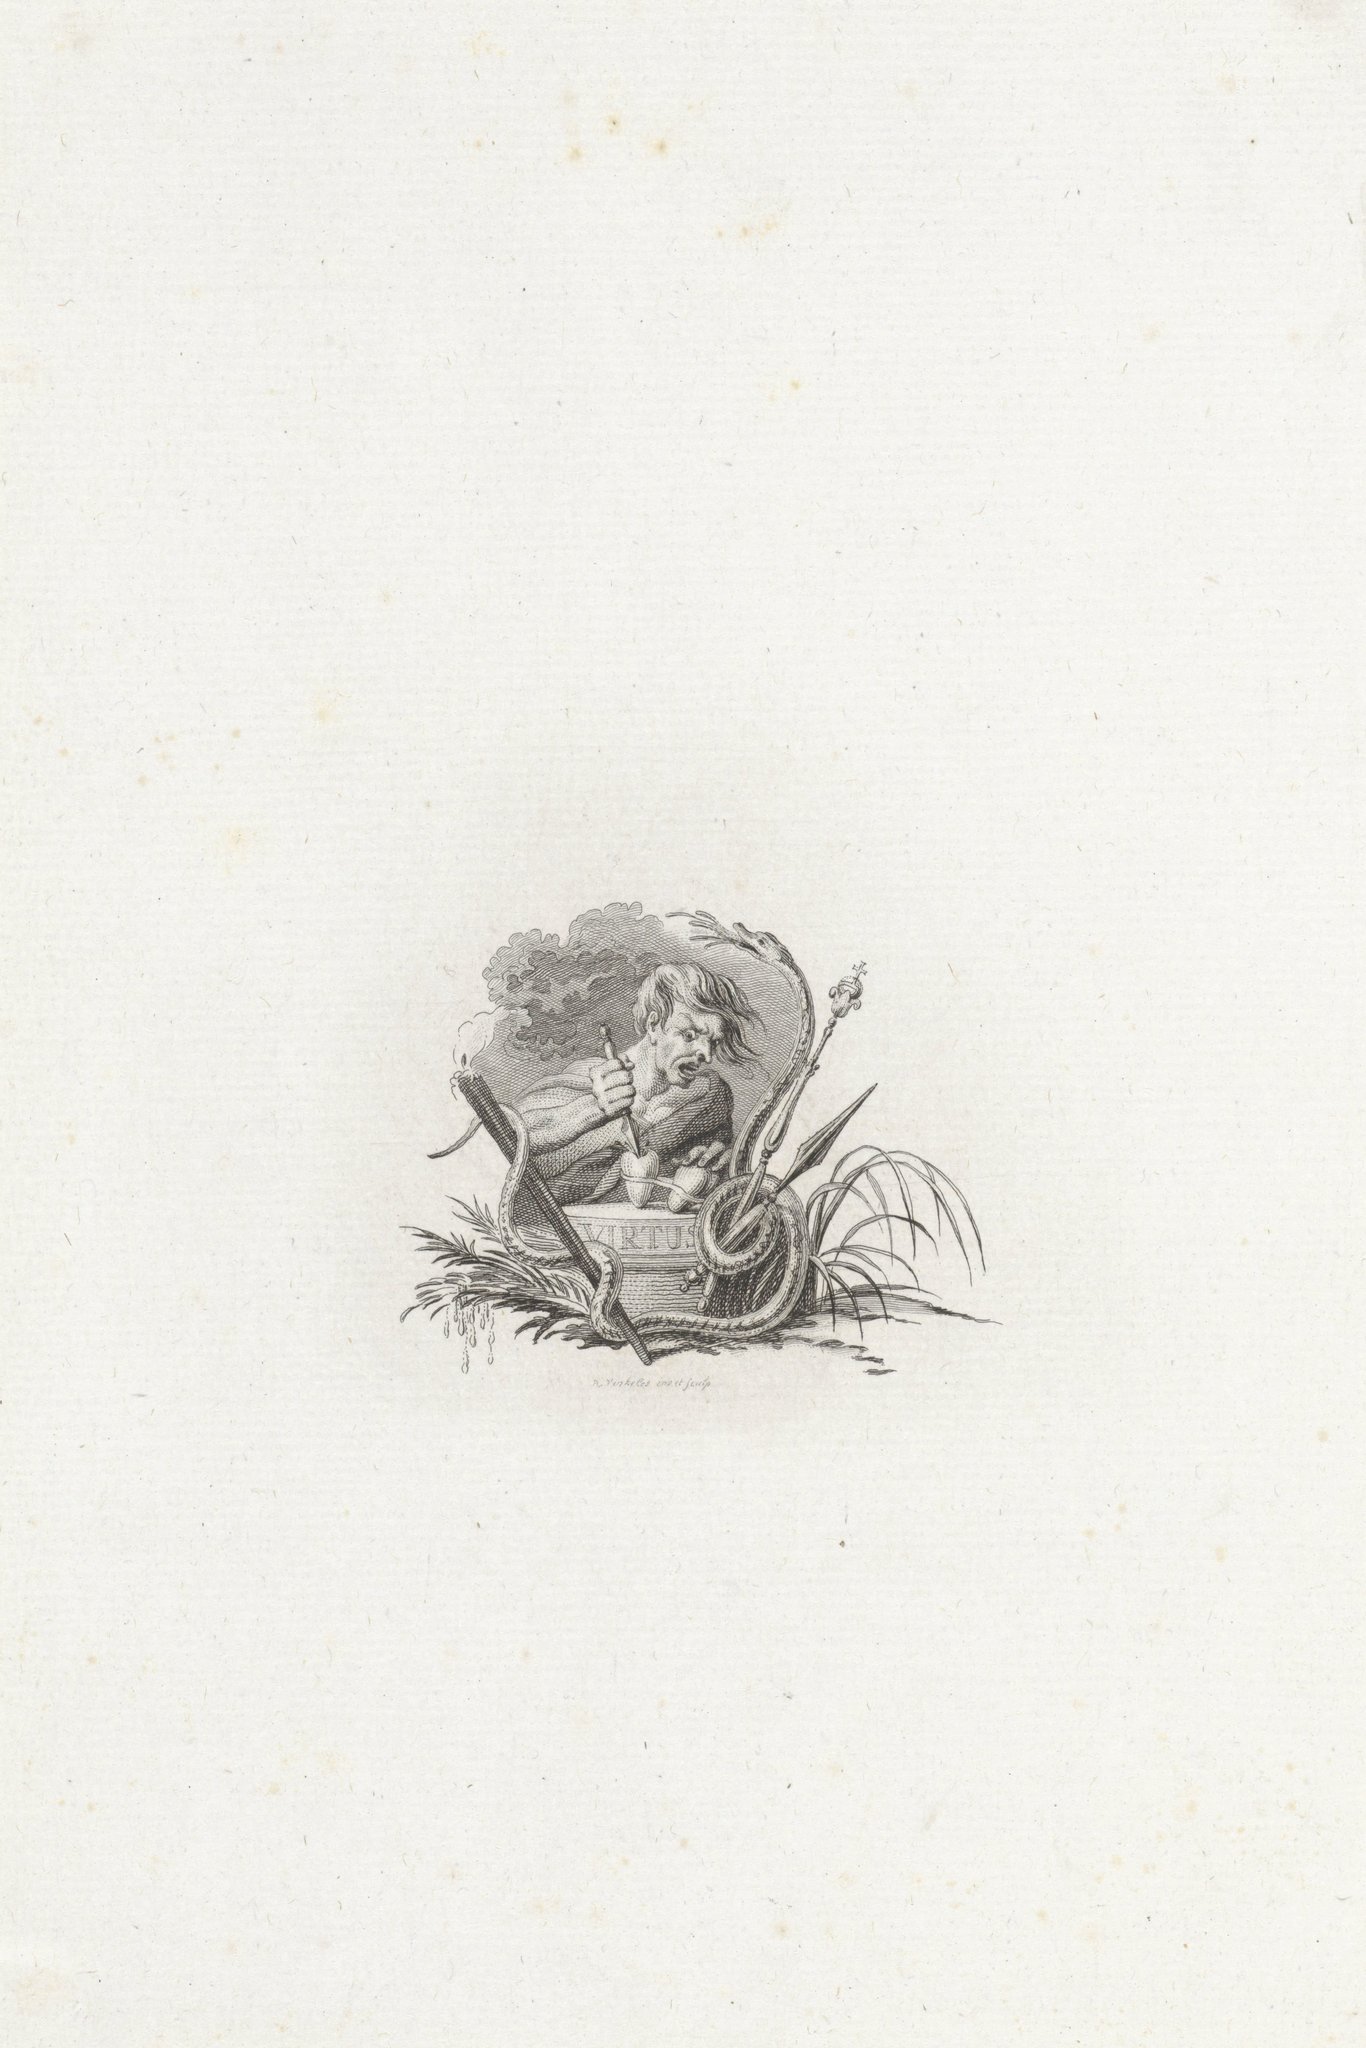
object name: print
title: Titelprent voor: Rhijnvis Feith, 'Ines de Castro', 1793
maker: reinier vinkeles (i)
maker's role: draughtsman, print maker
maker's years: 1741-1816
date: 1793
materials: paper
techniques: engraving, etching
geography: amsterdam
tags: snakes, envy; 'invidia' (ripa) ~ personification of one of the seven deadly sins, candle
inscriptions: collector's mark: Lugt 240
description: Proefdruk van titelpagina voor: Feith, Rhijnvis. Ines de Castro. Amsterdam: Johannes Allart, 1793.